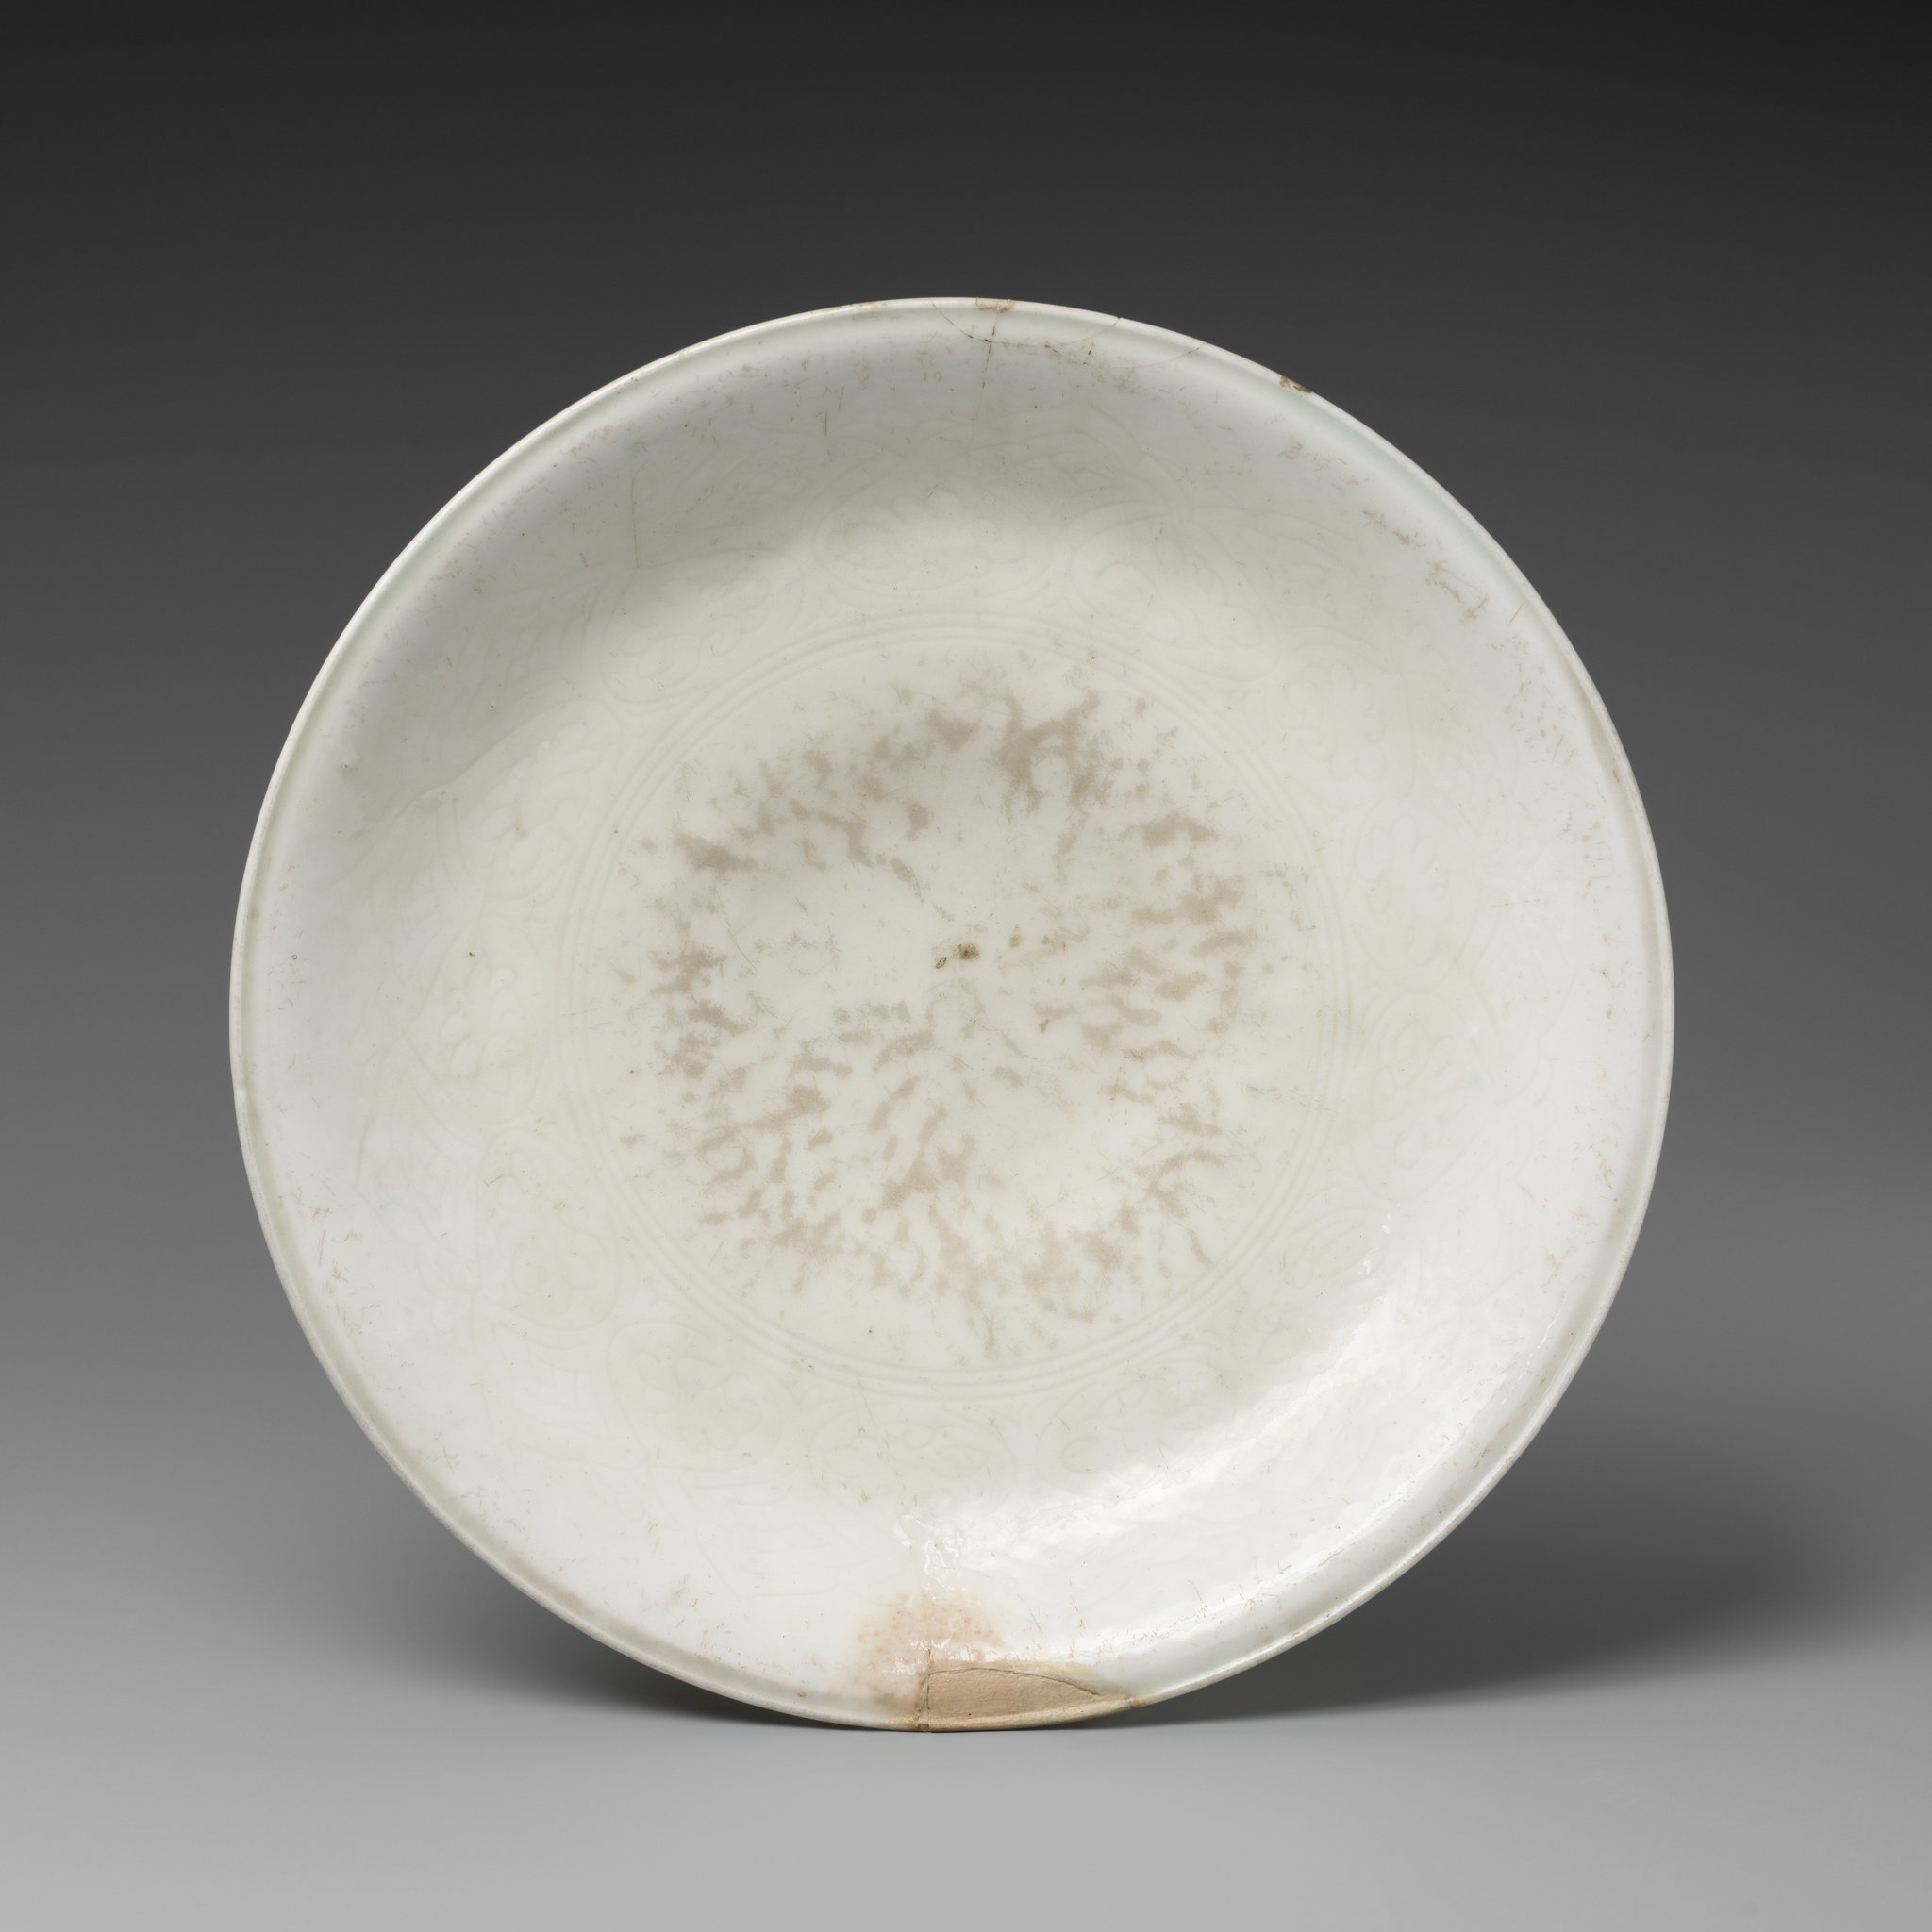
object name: dish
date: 1701-1800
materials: porcelain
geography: iran